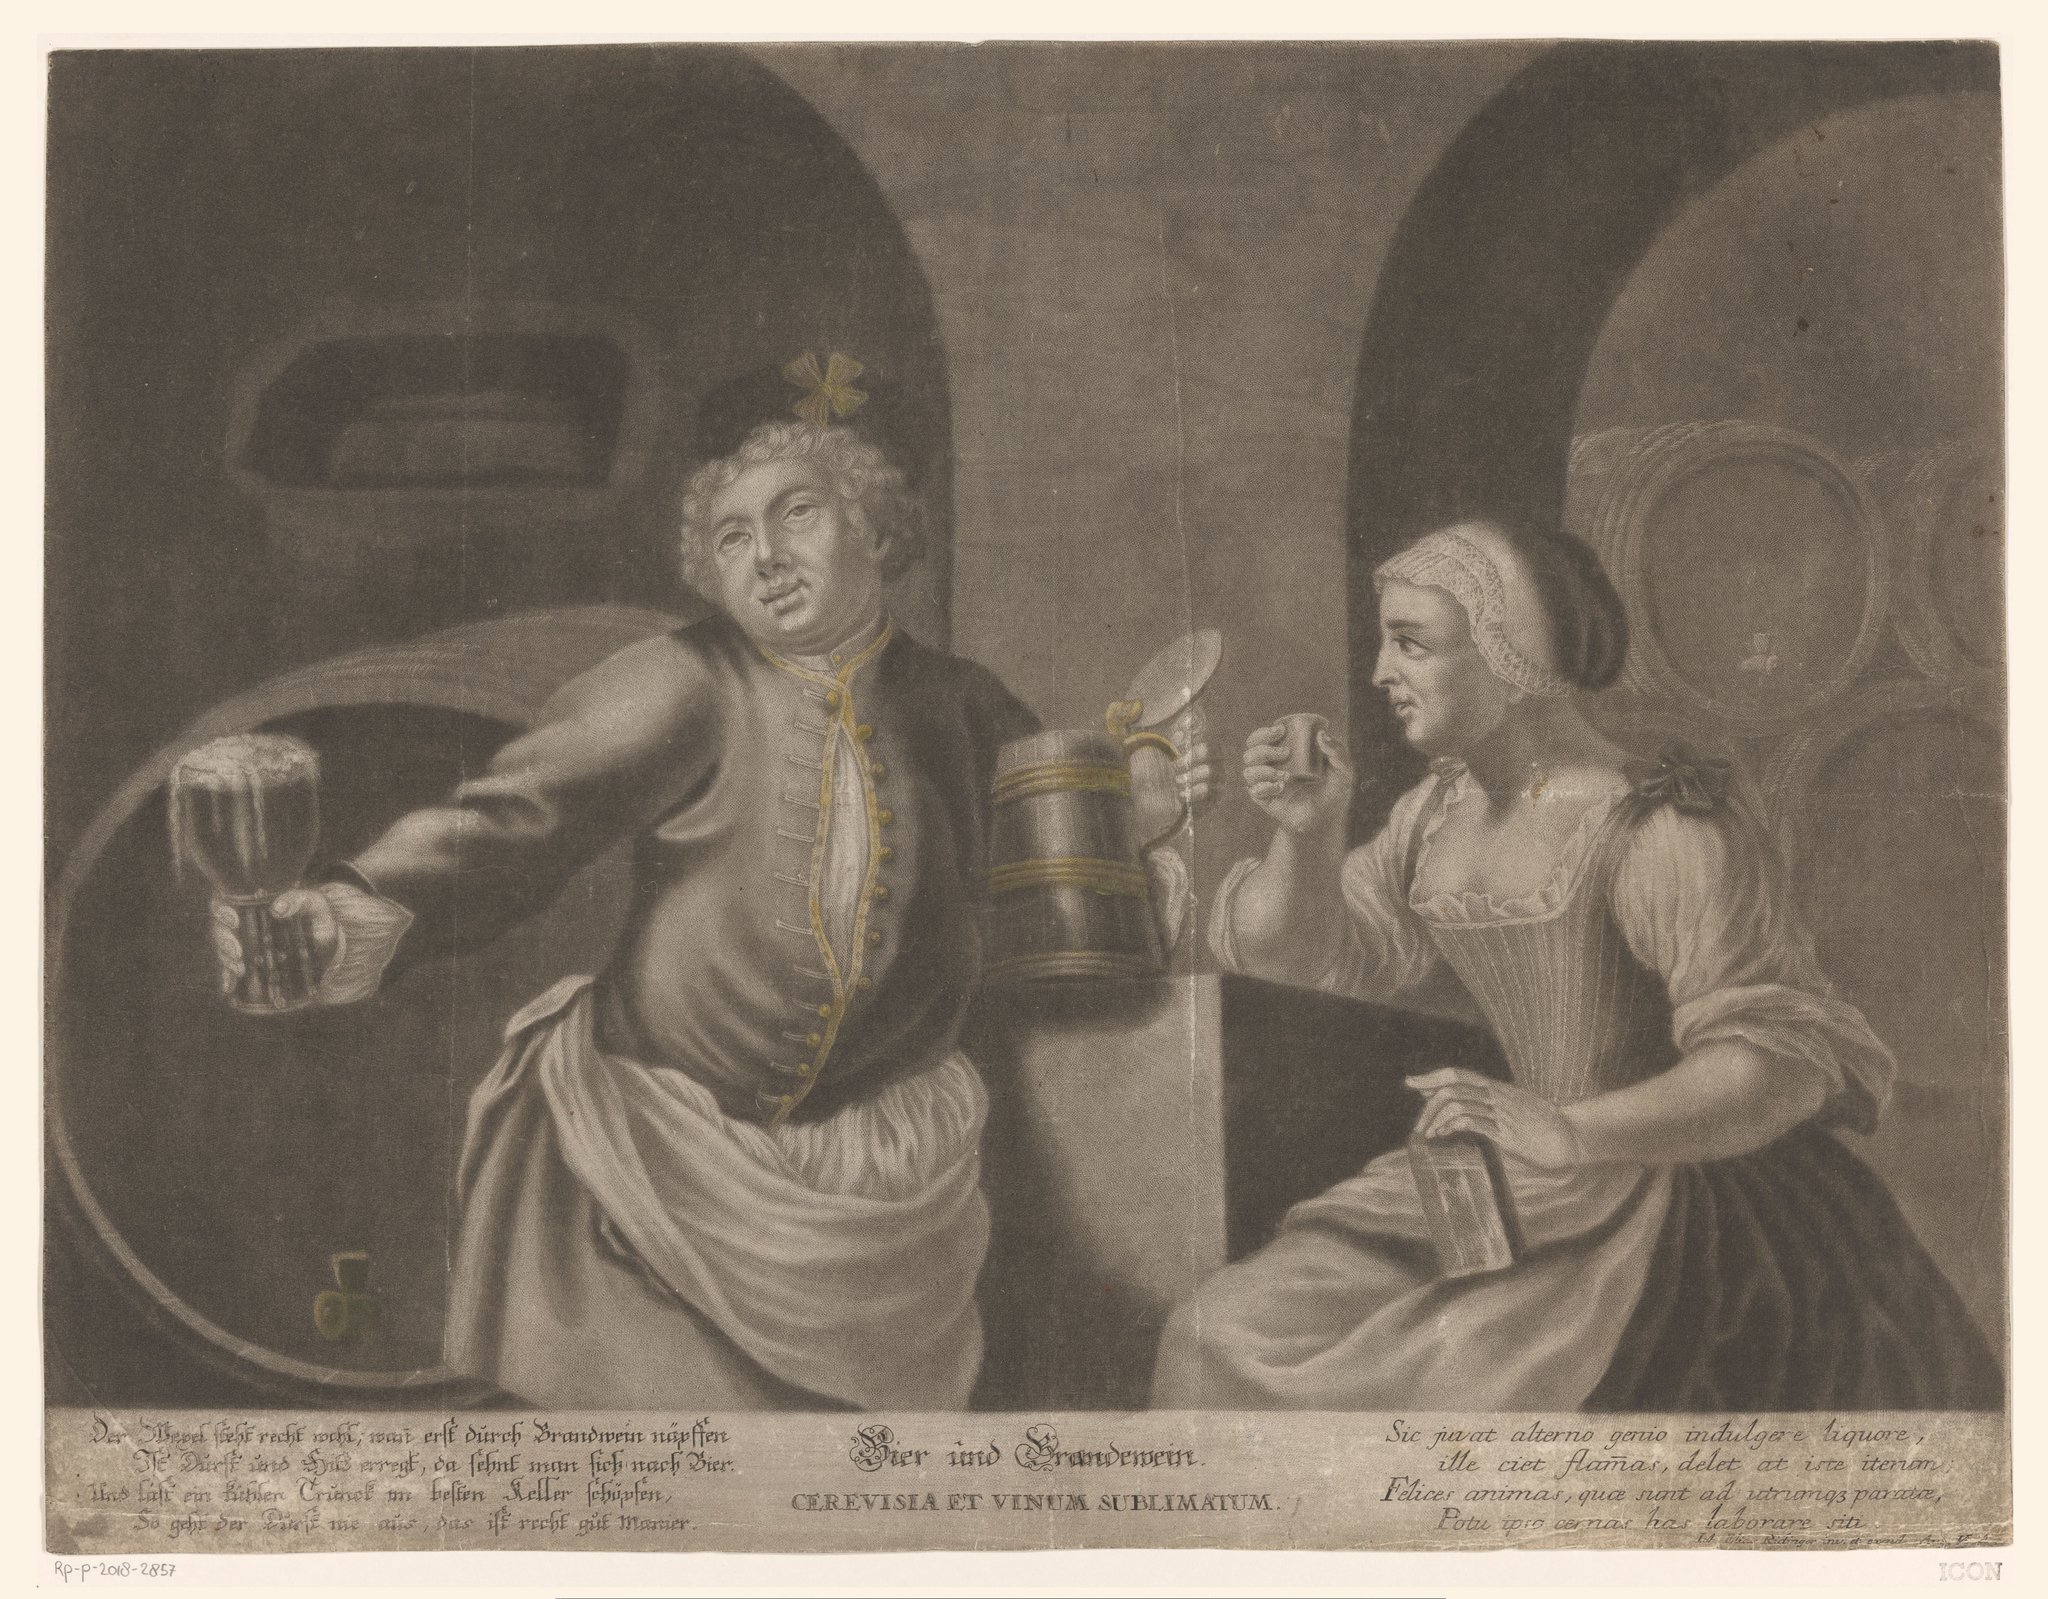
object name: print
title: Man en vrouw drinken bier en brandewijn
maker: johann elias ridinger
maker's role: draughtsman, painter, print maker, publisher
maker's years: 1698-1767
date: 1708-1767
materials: paper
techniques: hand coloring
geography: augsburg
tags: wooden container: barrel, cask, bucket, brandy, brandywine, beer, ale, drinking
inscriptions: collector's mark: Lugt 2228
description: Met onderschrift in het Duits en het Latijn.